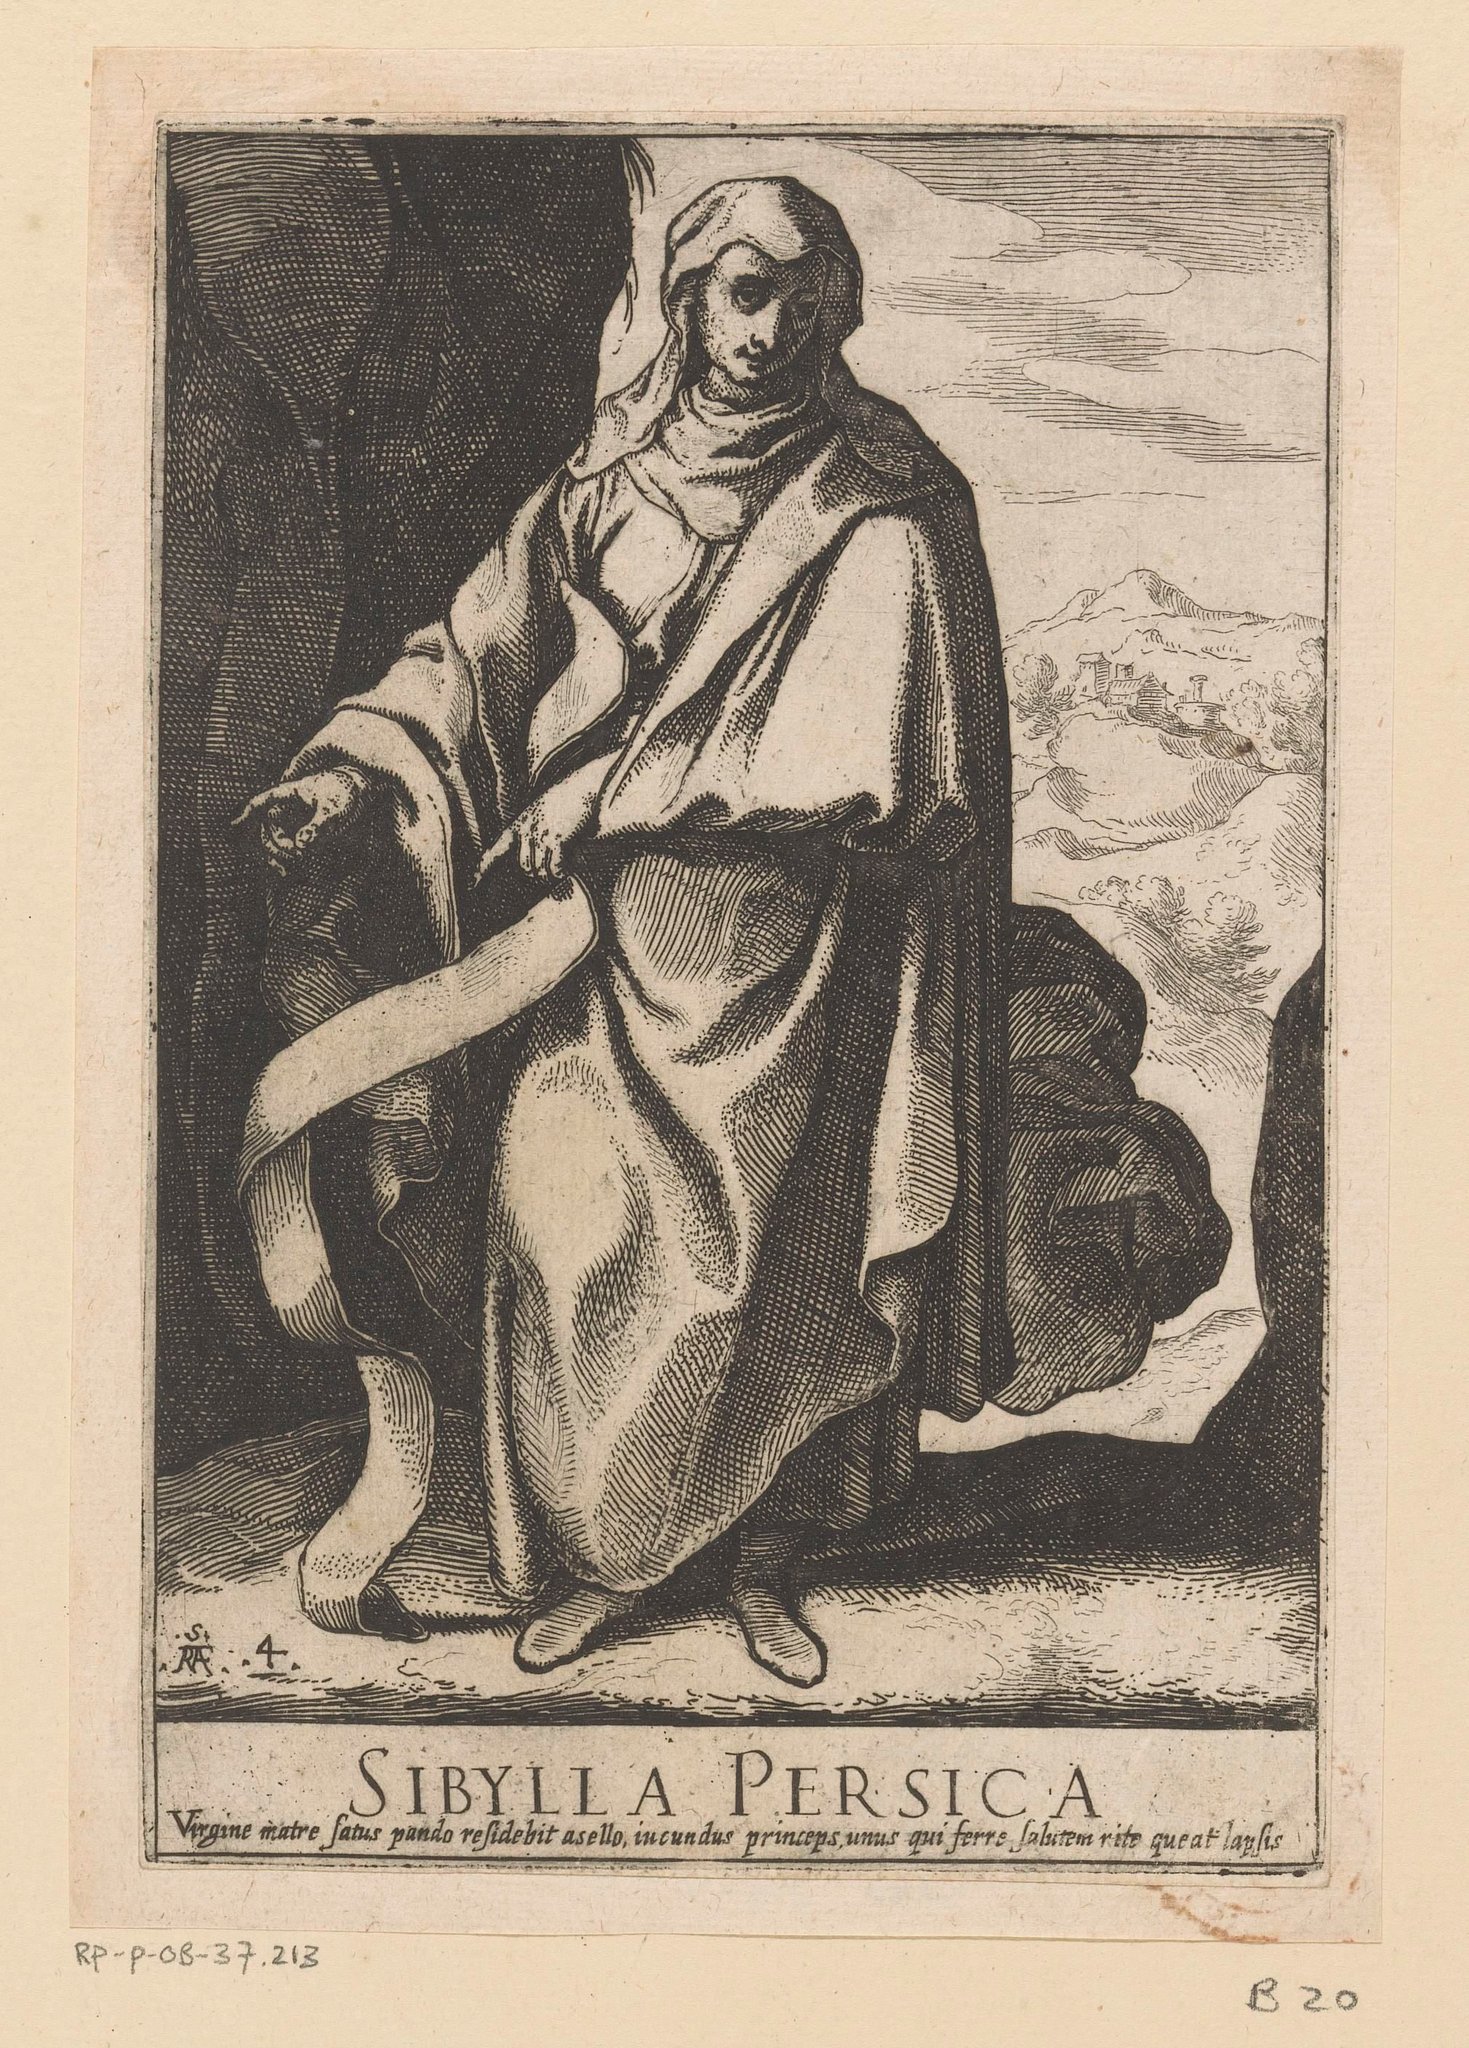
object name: print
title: Sibylla Persica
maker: raffaello schiaminossi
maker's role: painter, print maker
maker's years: 1572-1622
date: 1606-1609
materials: paper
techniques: etching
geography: italy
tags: banderole, persian sibyl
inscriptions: collector's mark: Lugt 240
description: Deze prent maakt deel uit van een serie bestaande uit een titelprent en tien prenten met voorstellingen van Sibillen. De serie is drie keer uitgegeven: eenmaal in 1606 en tweemaal in 1609 door verschillende uitgevers. Om deze reden worden de prenten uit deze serie hier 1606-1609 gedateerd, behalve indien de individuele prent zelf gedateerd is.